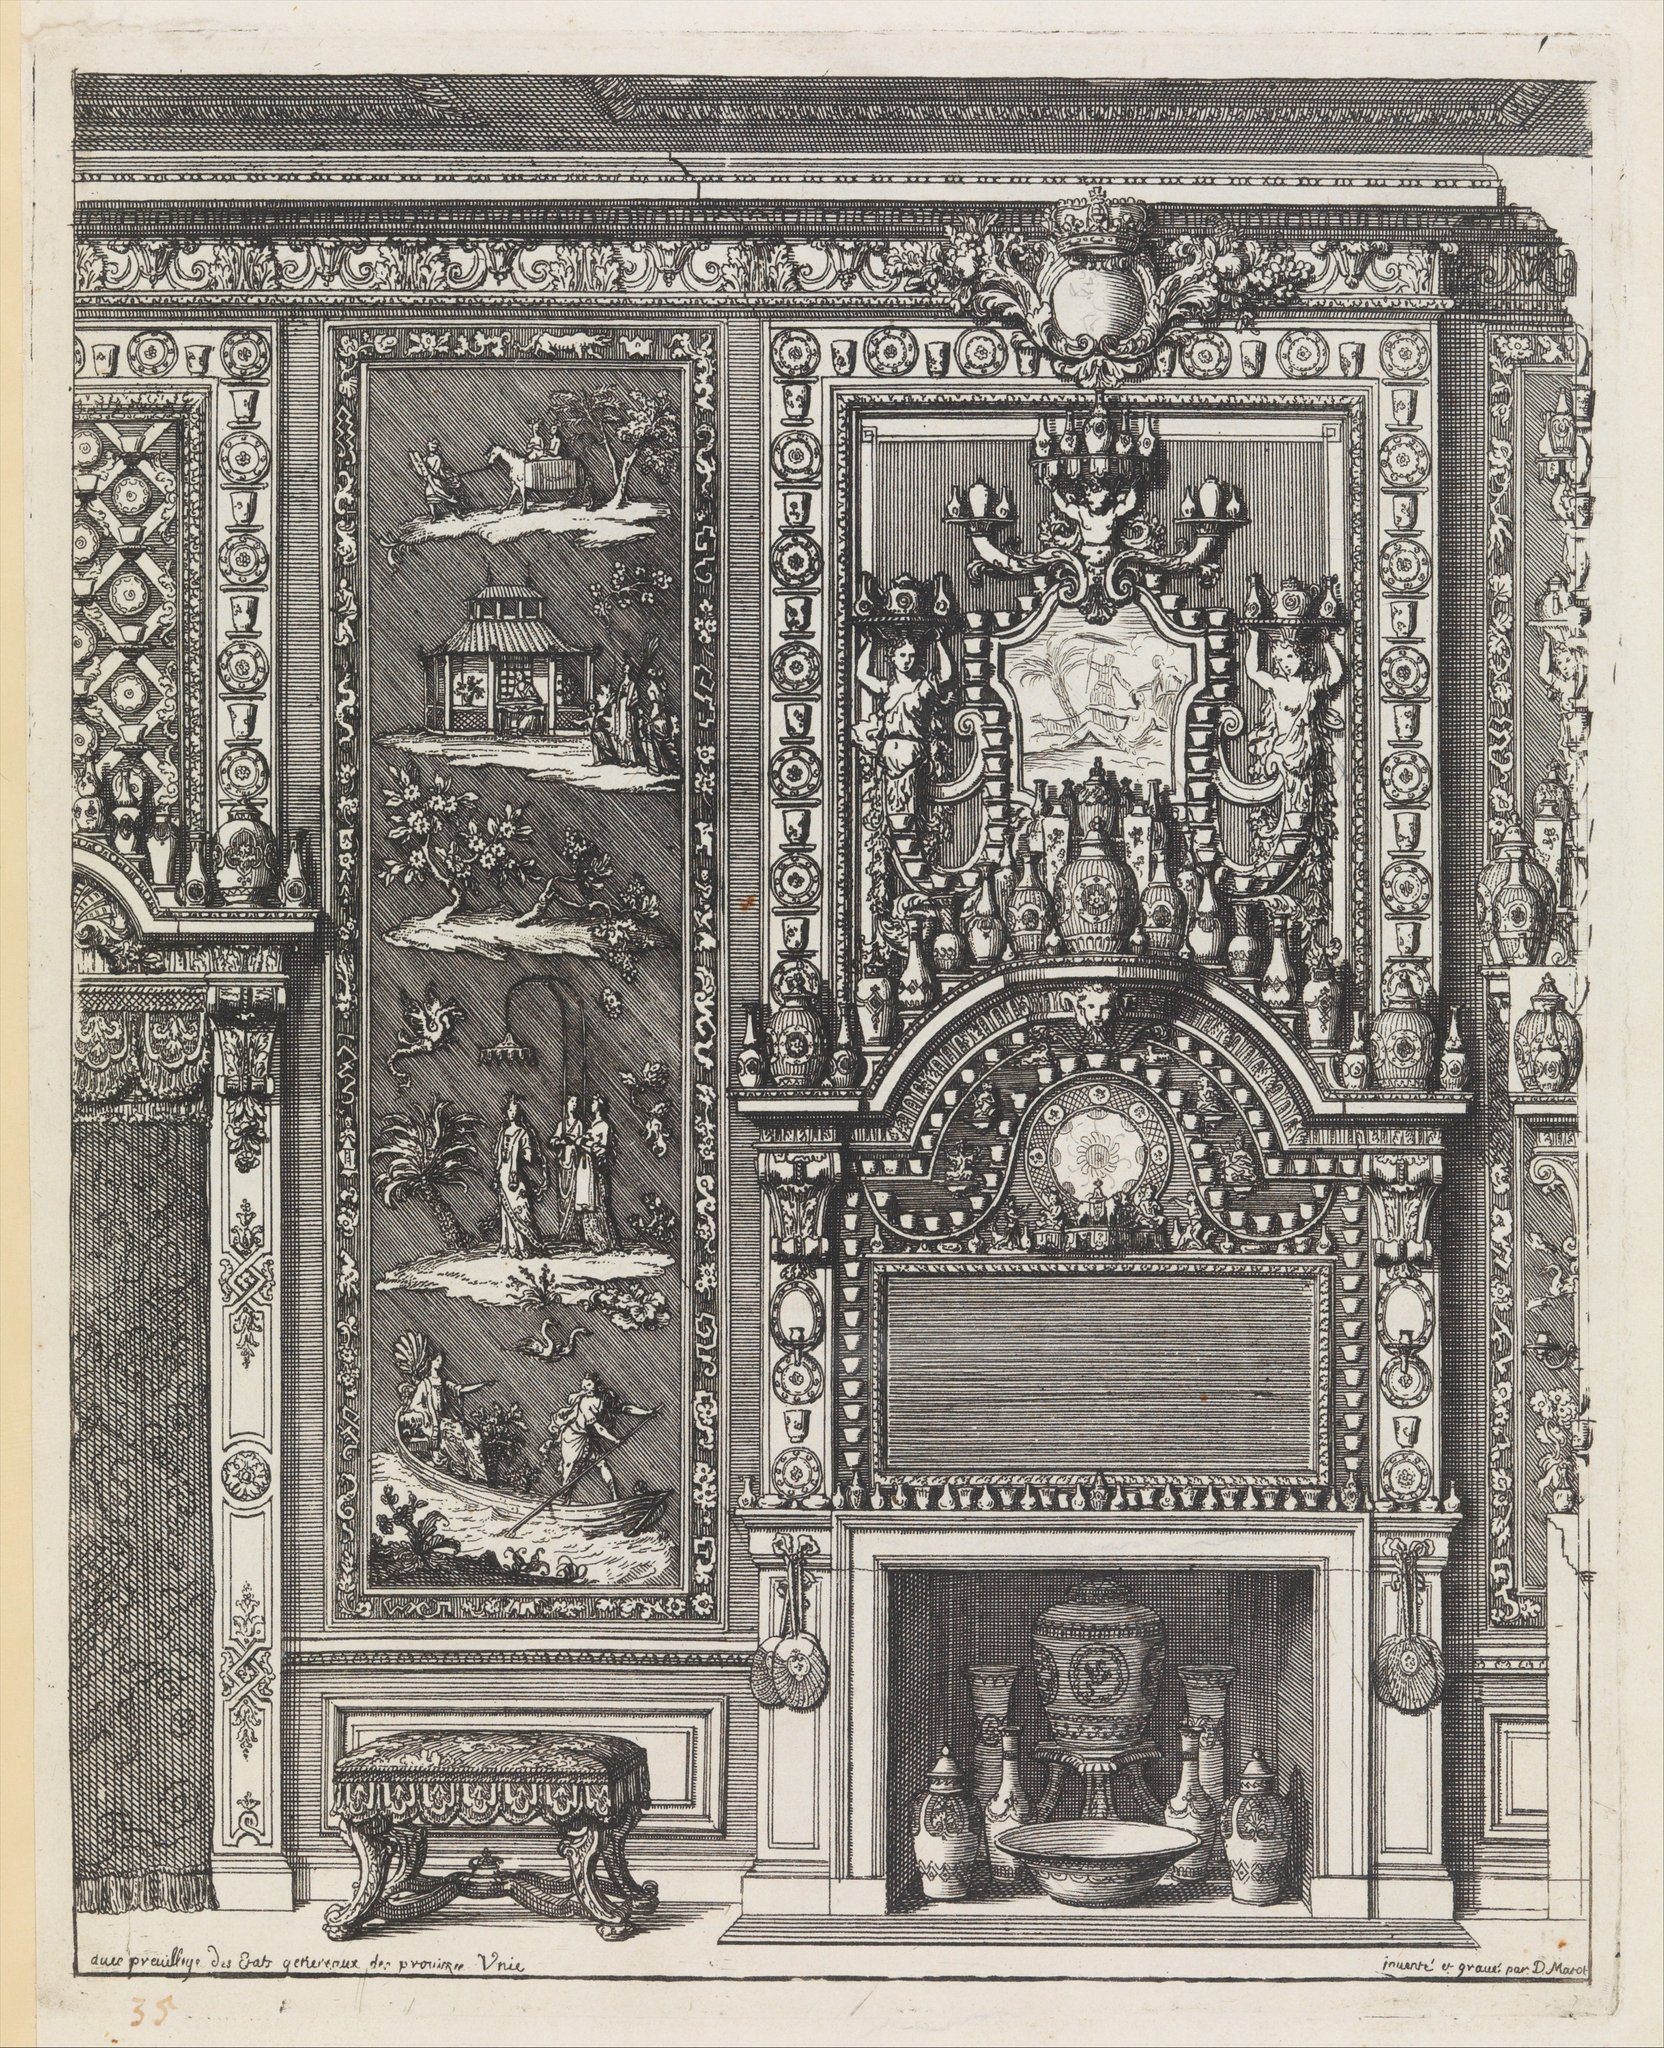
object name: book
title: Oeuvres du Sr. D. Marot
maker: daniel marot the elder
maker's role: artist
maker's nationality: french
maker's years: 1661-1752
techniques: engraving, etching, woodcut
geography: netherlands